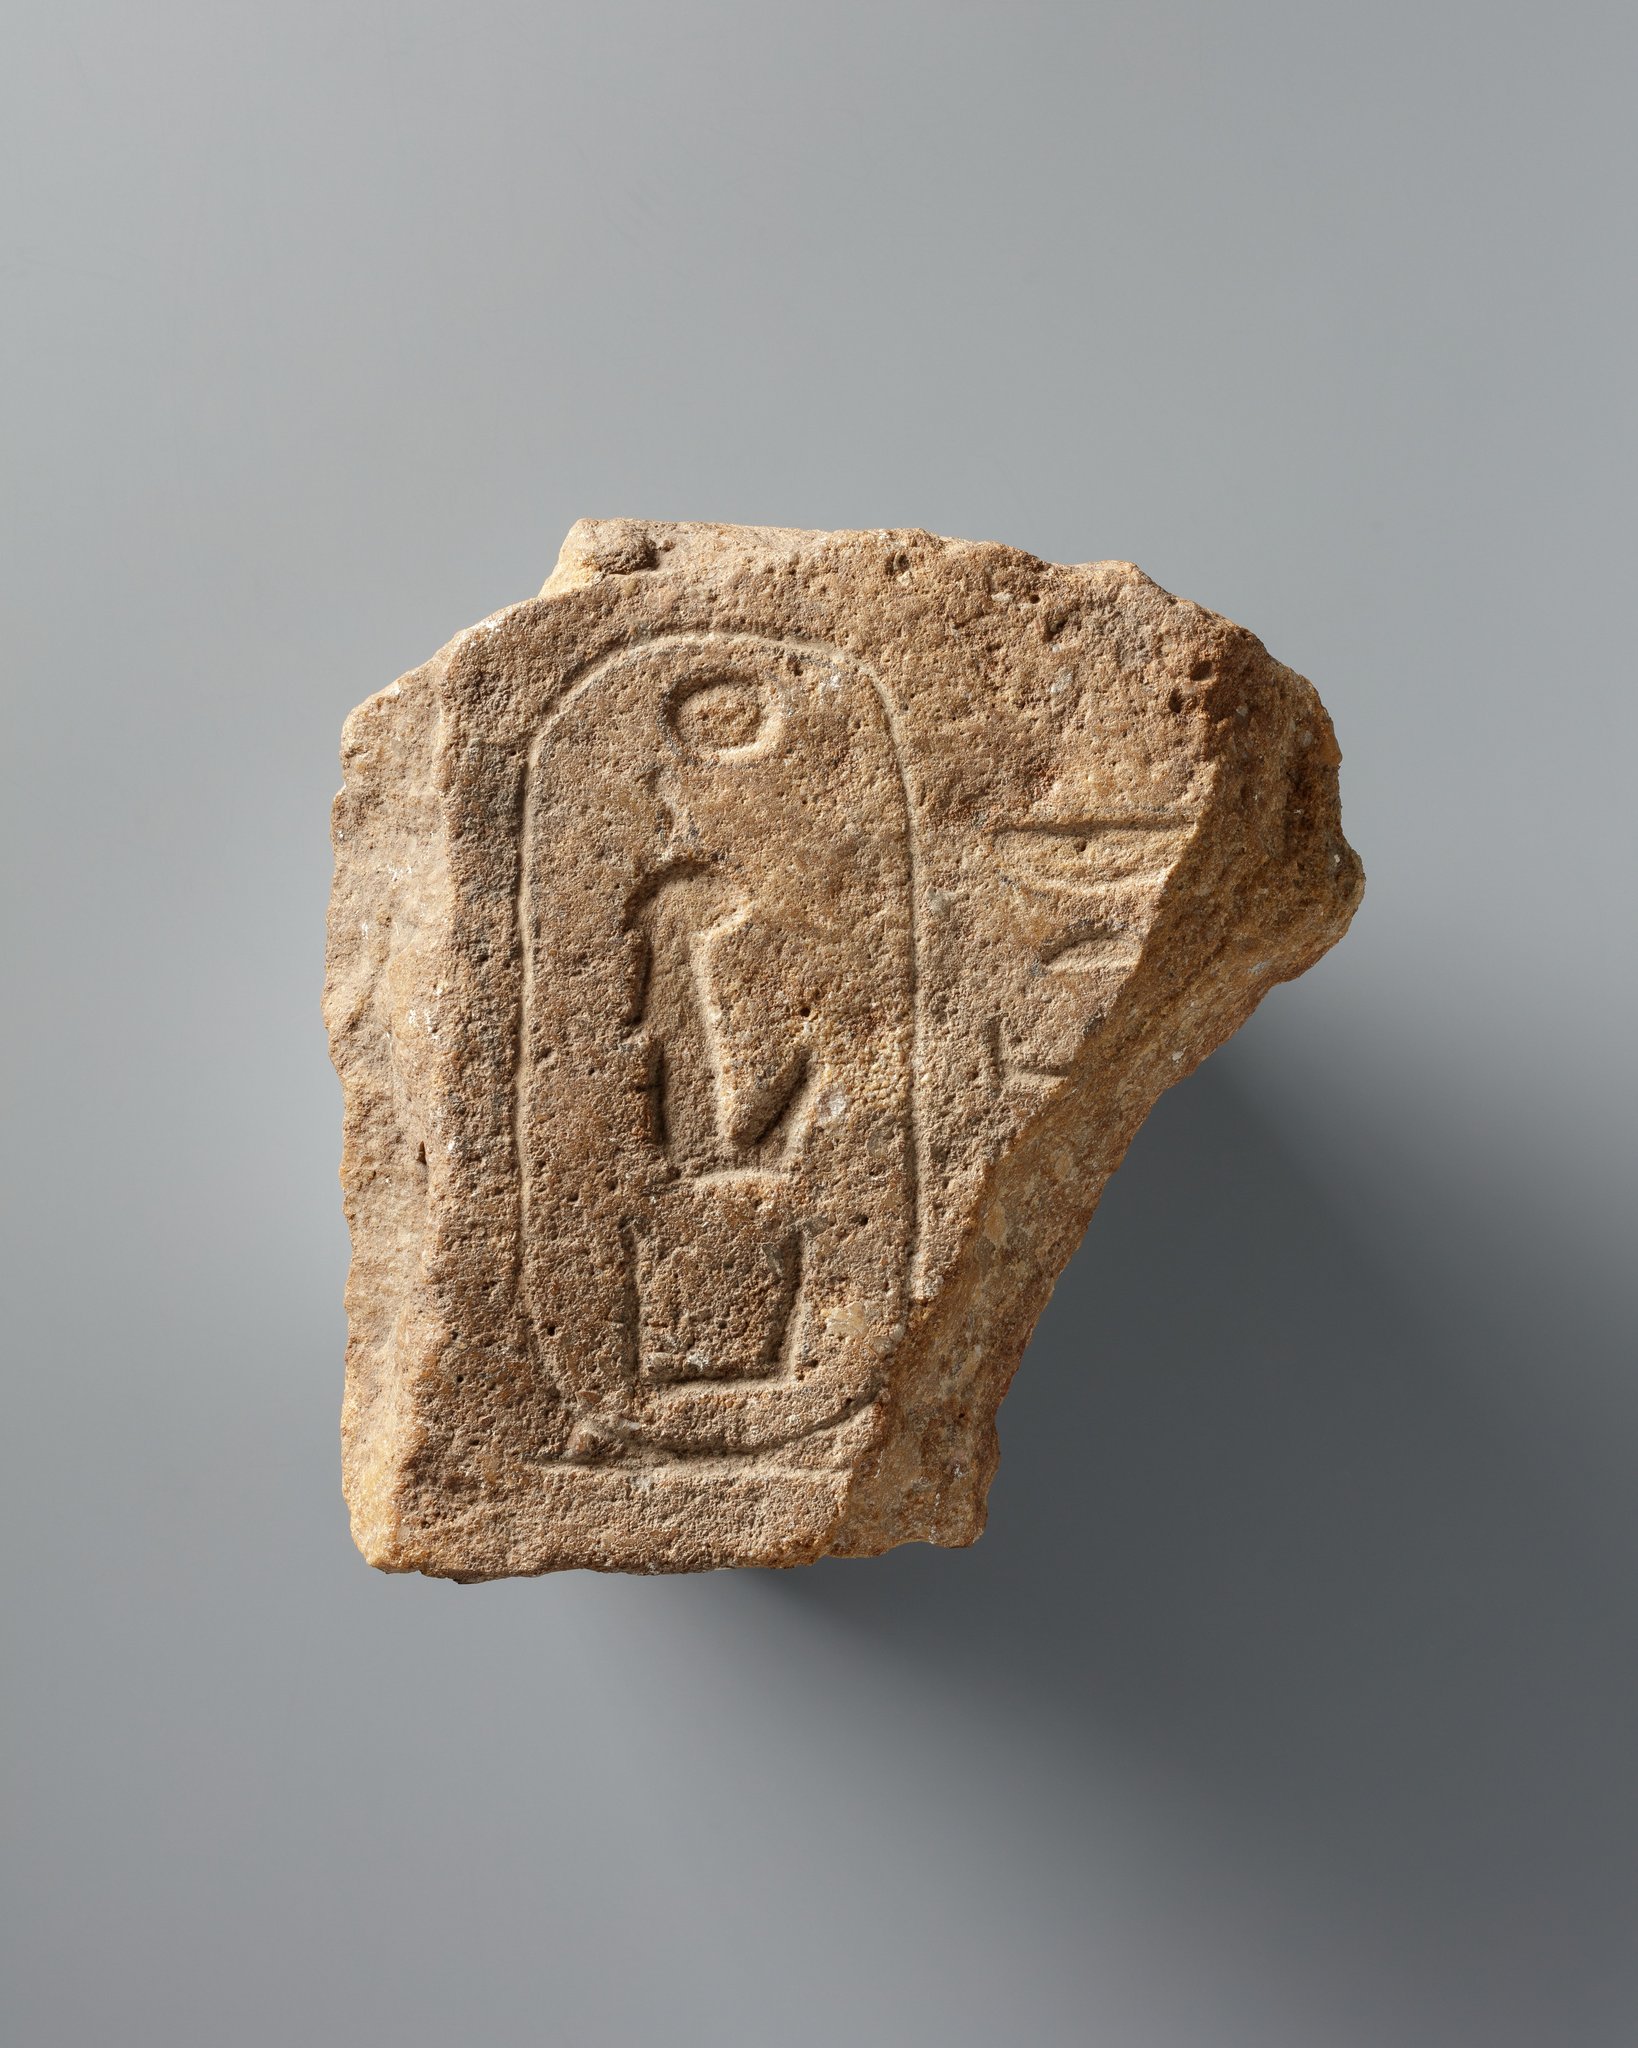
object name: name stone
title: Name Stone of Hatshepsut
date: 1479-1458 BCE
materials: quartzite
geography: egypt